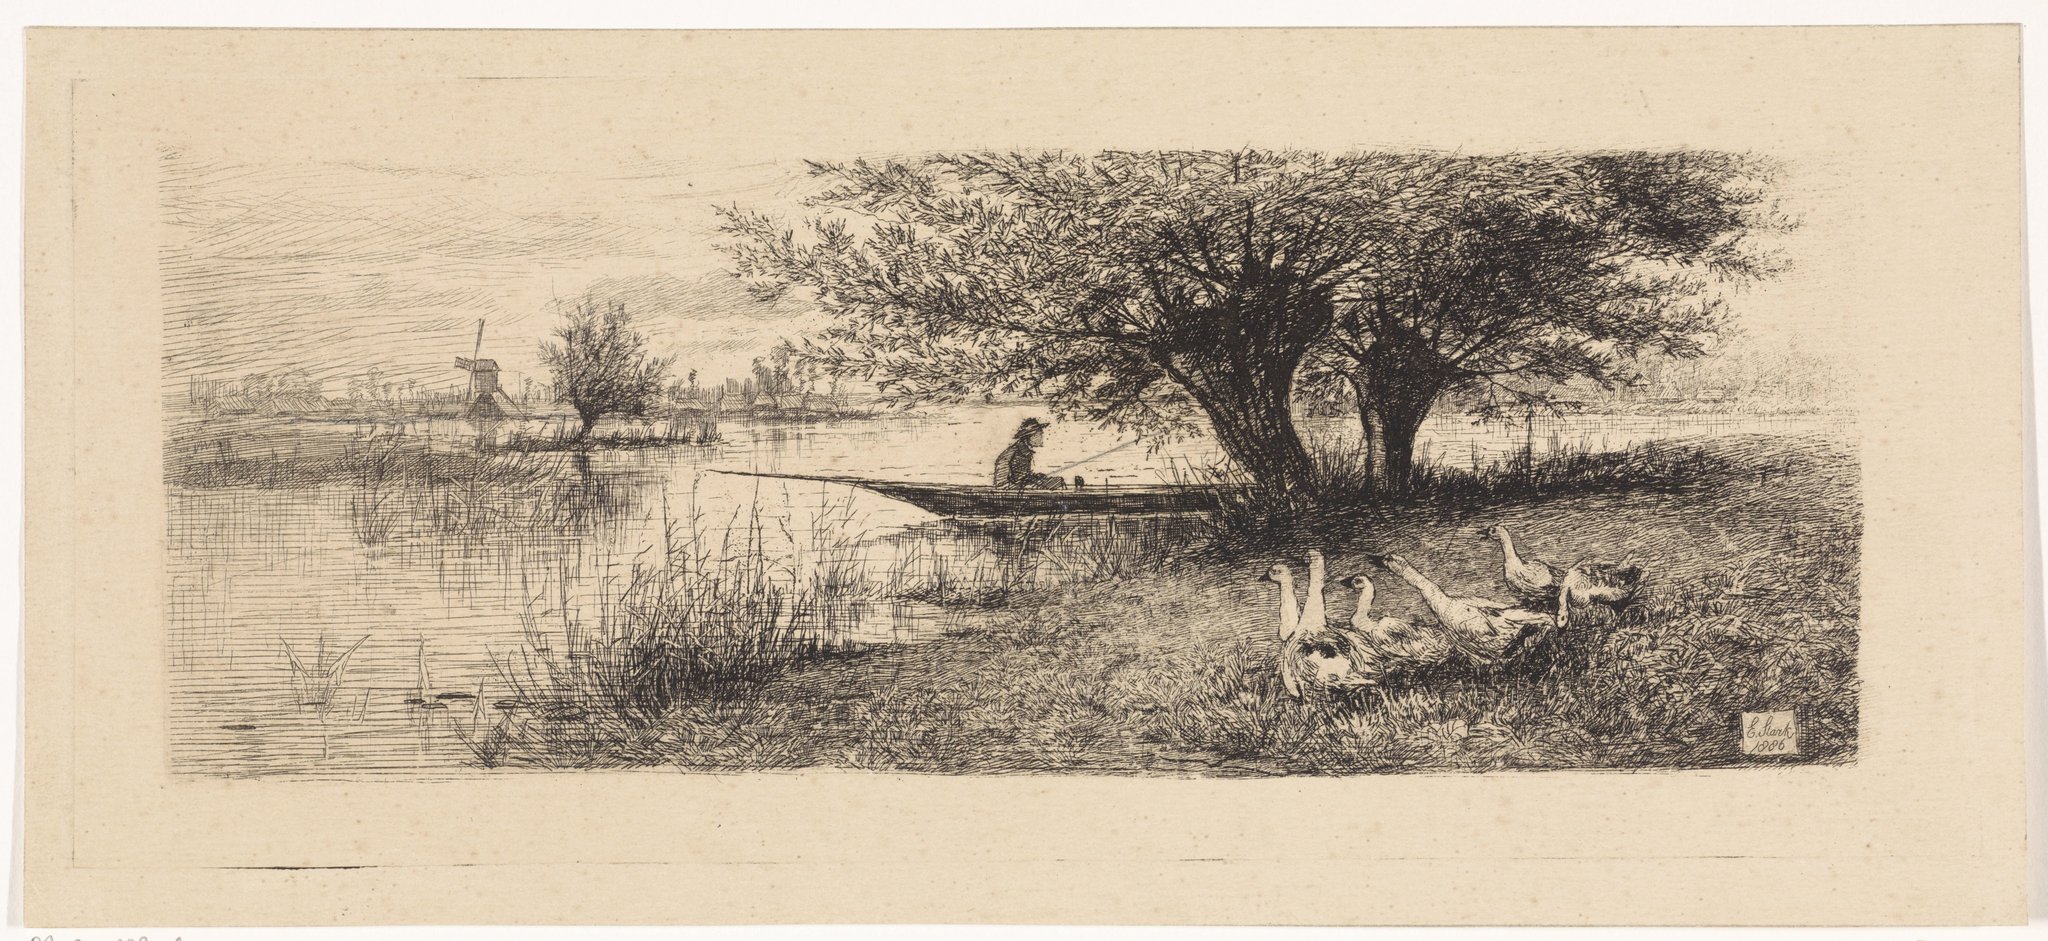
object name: print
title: Rivierlandschap met een man in een boot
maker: elias stark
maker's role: draughtsman, print maker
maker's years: 1849-1933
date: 1886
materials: paper, pencil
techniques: etching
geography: nieuwer-amstel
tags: river, rowing-boat, canoe, etc., trees: willow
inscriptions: collector's mark: Lugt 2228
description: Op een rivier een man in een boot bij twee knotwilgen. Links aan de horizon een molen.